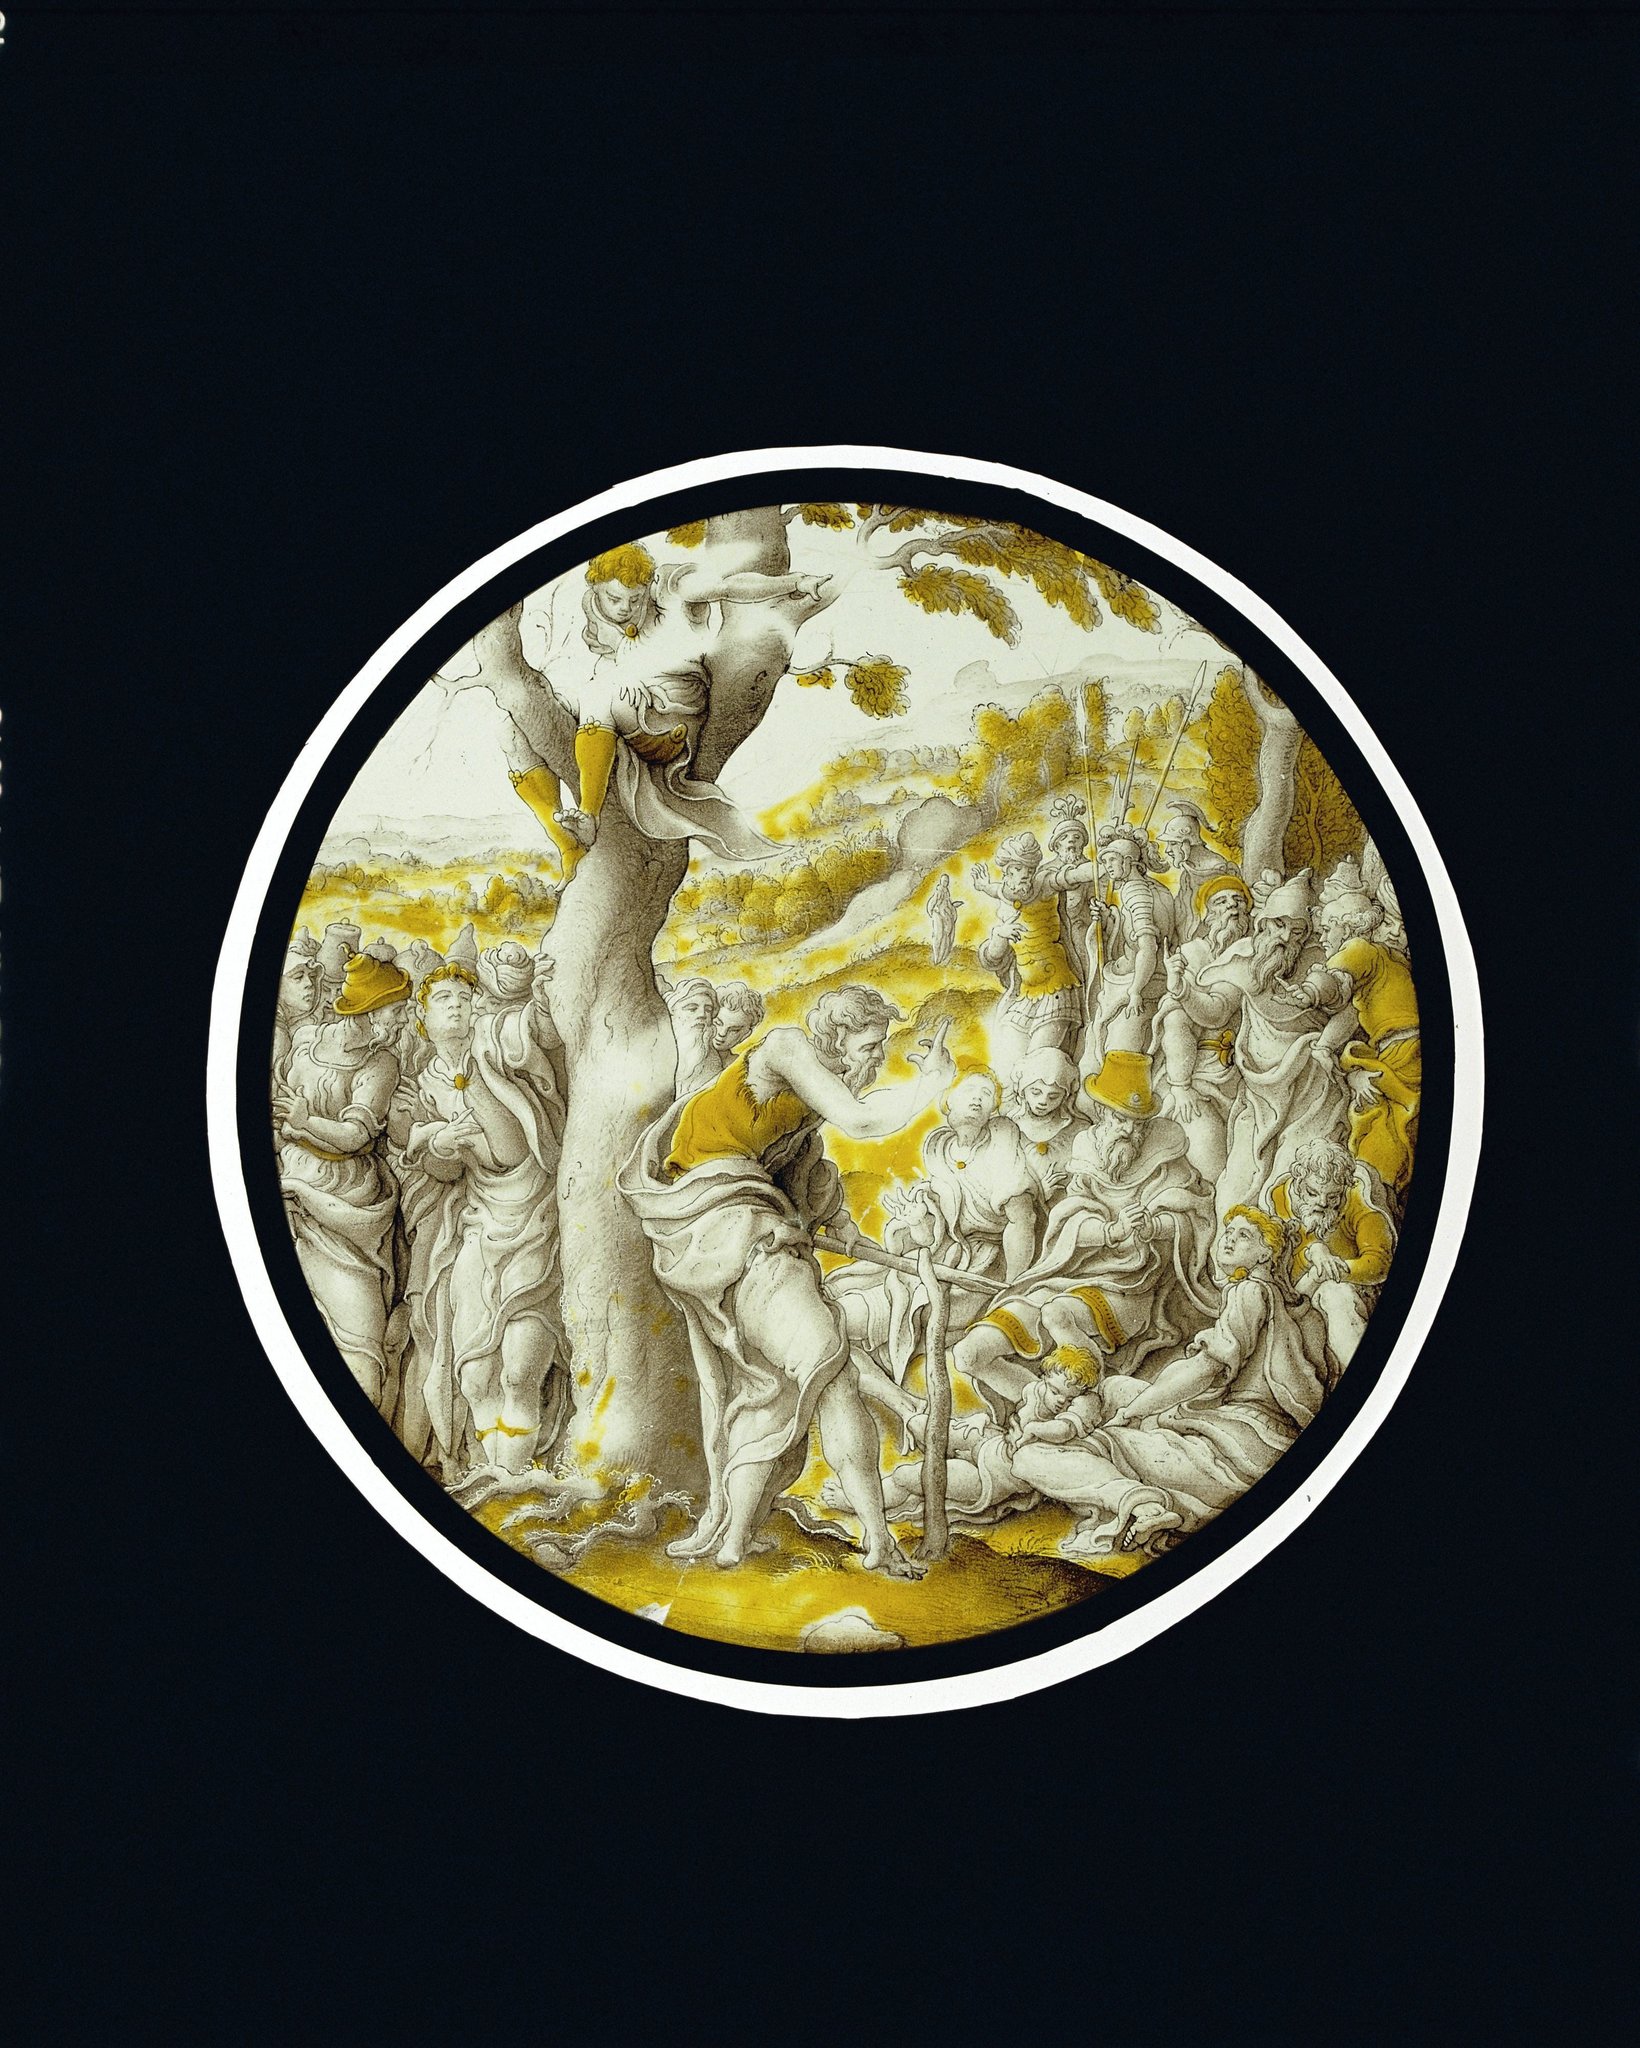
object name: light window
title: Saint John the Baptist Preaching in the Wilderness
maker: Anonymous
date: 1540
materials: glass, lead, pigment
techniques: leading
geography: southern netherlands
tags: john the baptist identifies christ as the lamb of god ('ecce agnus dei') (john 1:29, 1:36), john the baptist preaching (perhaps christ among the bystanders)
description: Ronde gebrandschilderde ruit met voorstelling van Johannes de Doper predikend in de woestijn. Hij is afgebeeld sprekend vanaf een geïmproviseerd spreekgestoelte bestaande uit stokken, leunend tegen de sterk getordeerde stam van een boom. Onder het publiek bevinden zich tollenaars en soldaten.